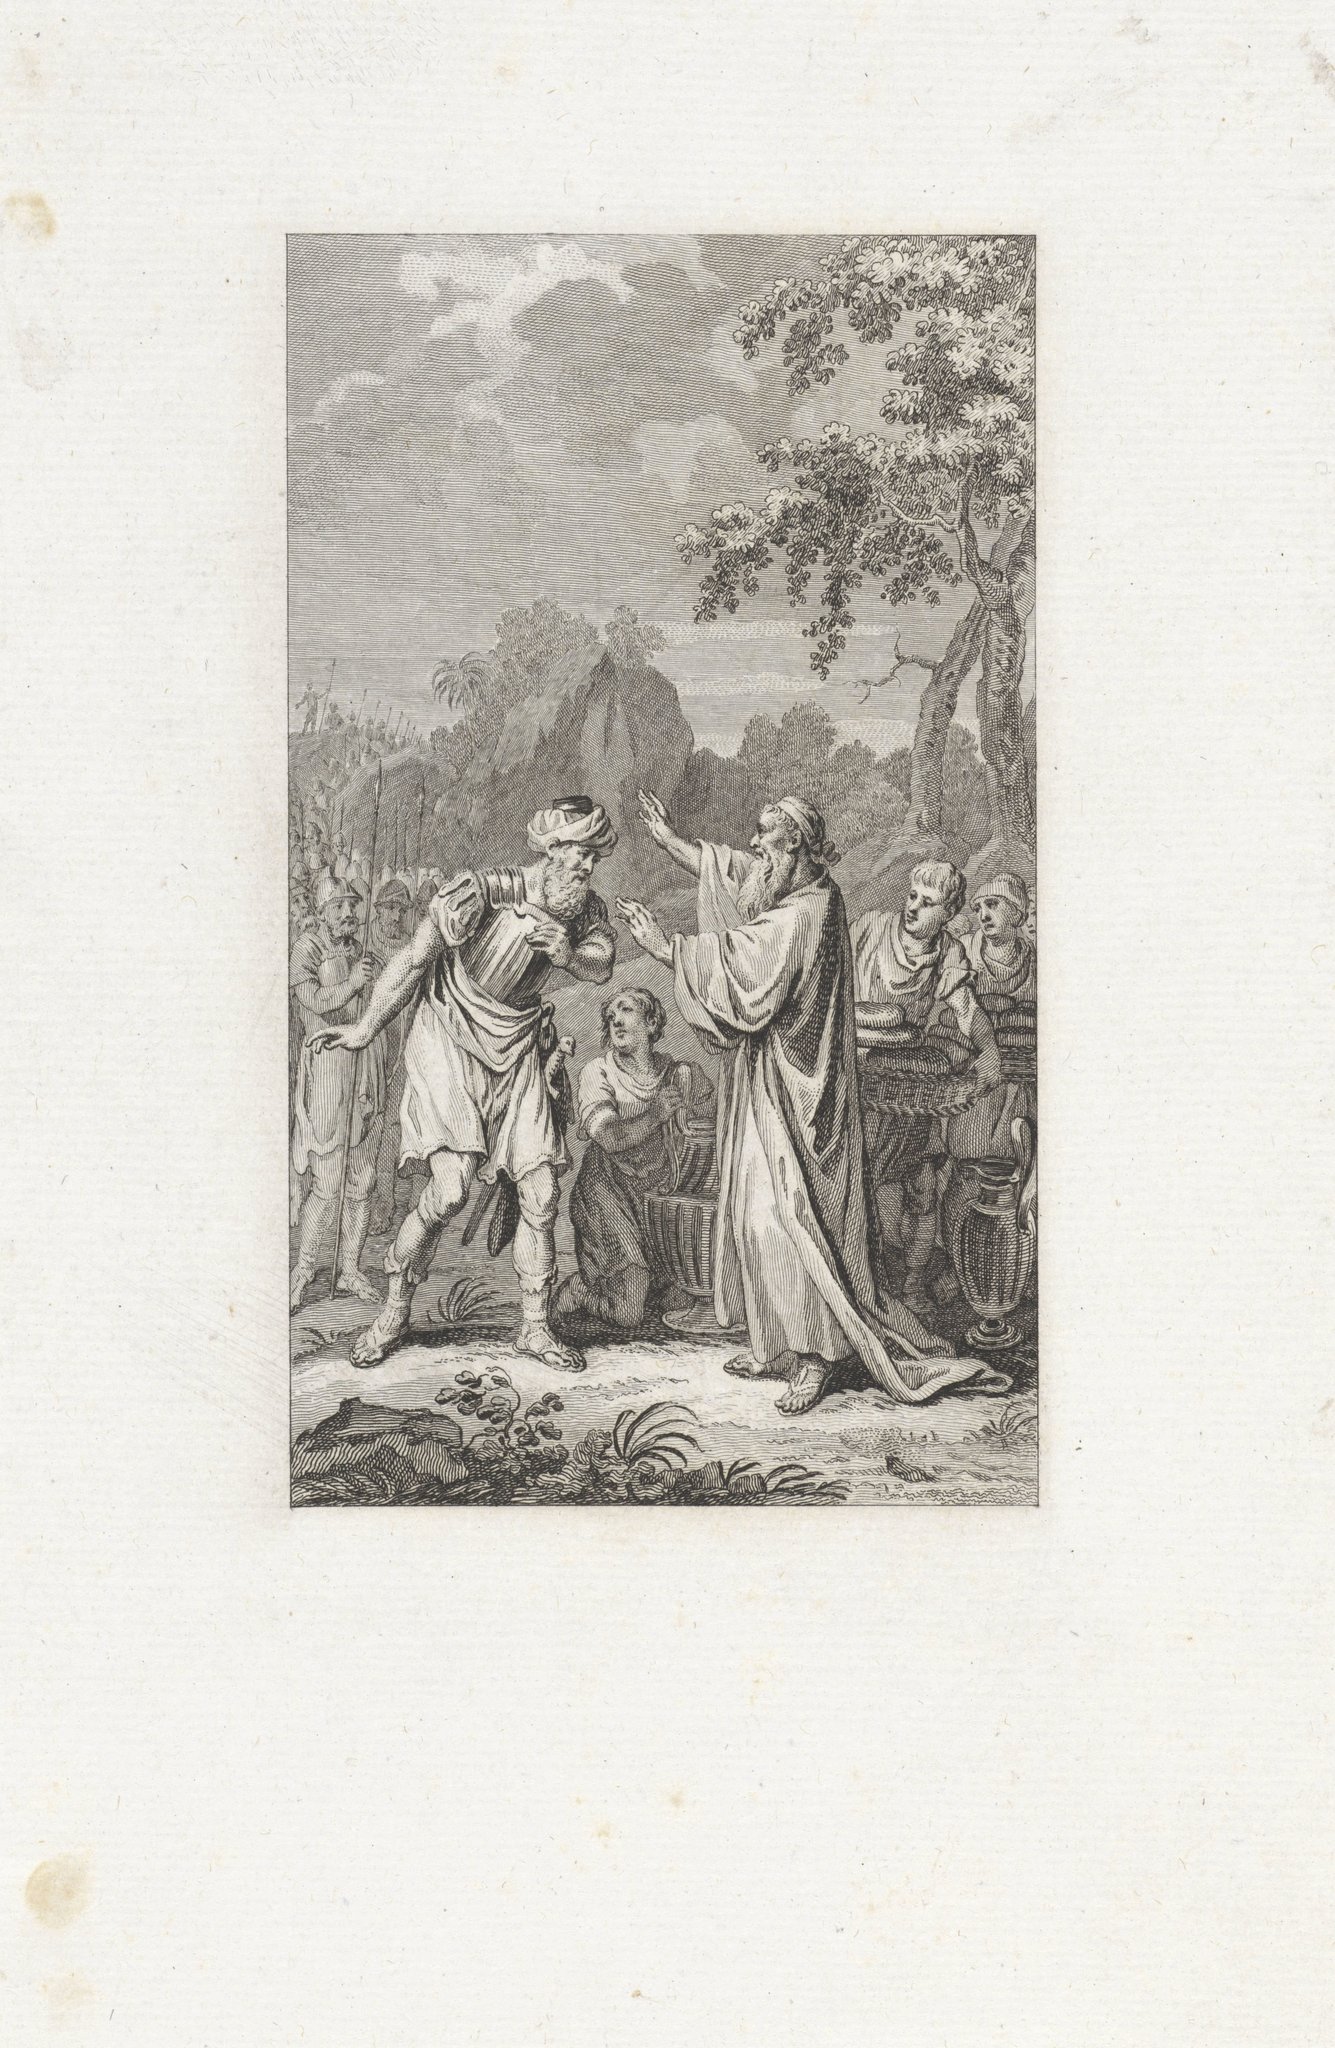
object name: print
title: Abrahams ontmoeting met Melchisedek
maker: reinier vinkeles (i)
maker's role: draughtsman, print maker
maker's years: 1741-1816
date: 1793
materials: paper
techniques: engraving, etching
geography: amsterdam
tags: the meeting of abraham and melchizedek, the high priest and king of salem, who brings bread and wine (genesis 14:18-20)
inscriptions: collector's mark: Lugt 240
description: Abraham ontmoet de koning en hogepriester Melchisedek in Salem. Hij brengt brood en wijn en zegent Abraham.